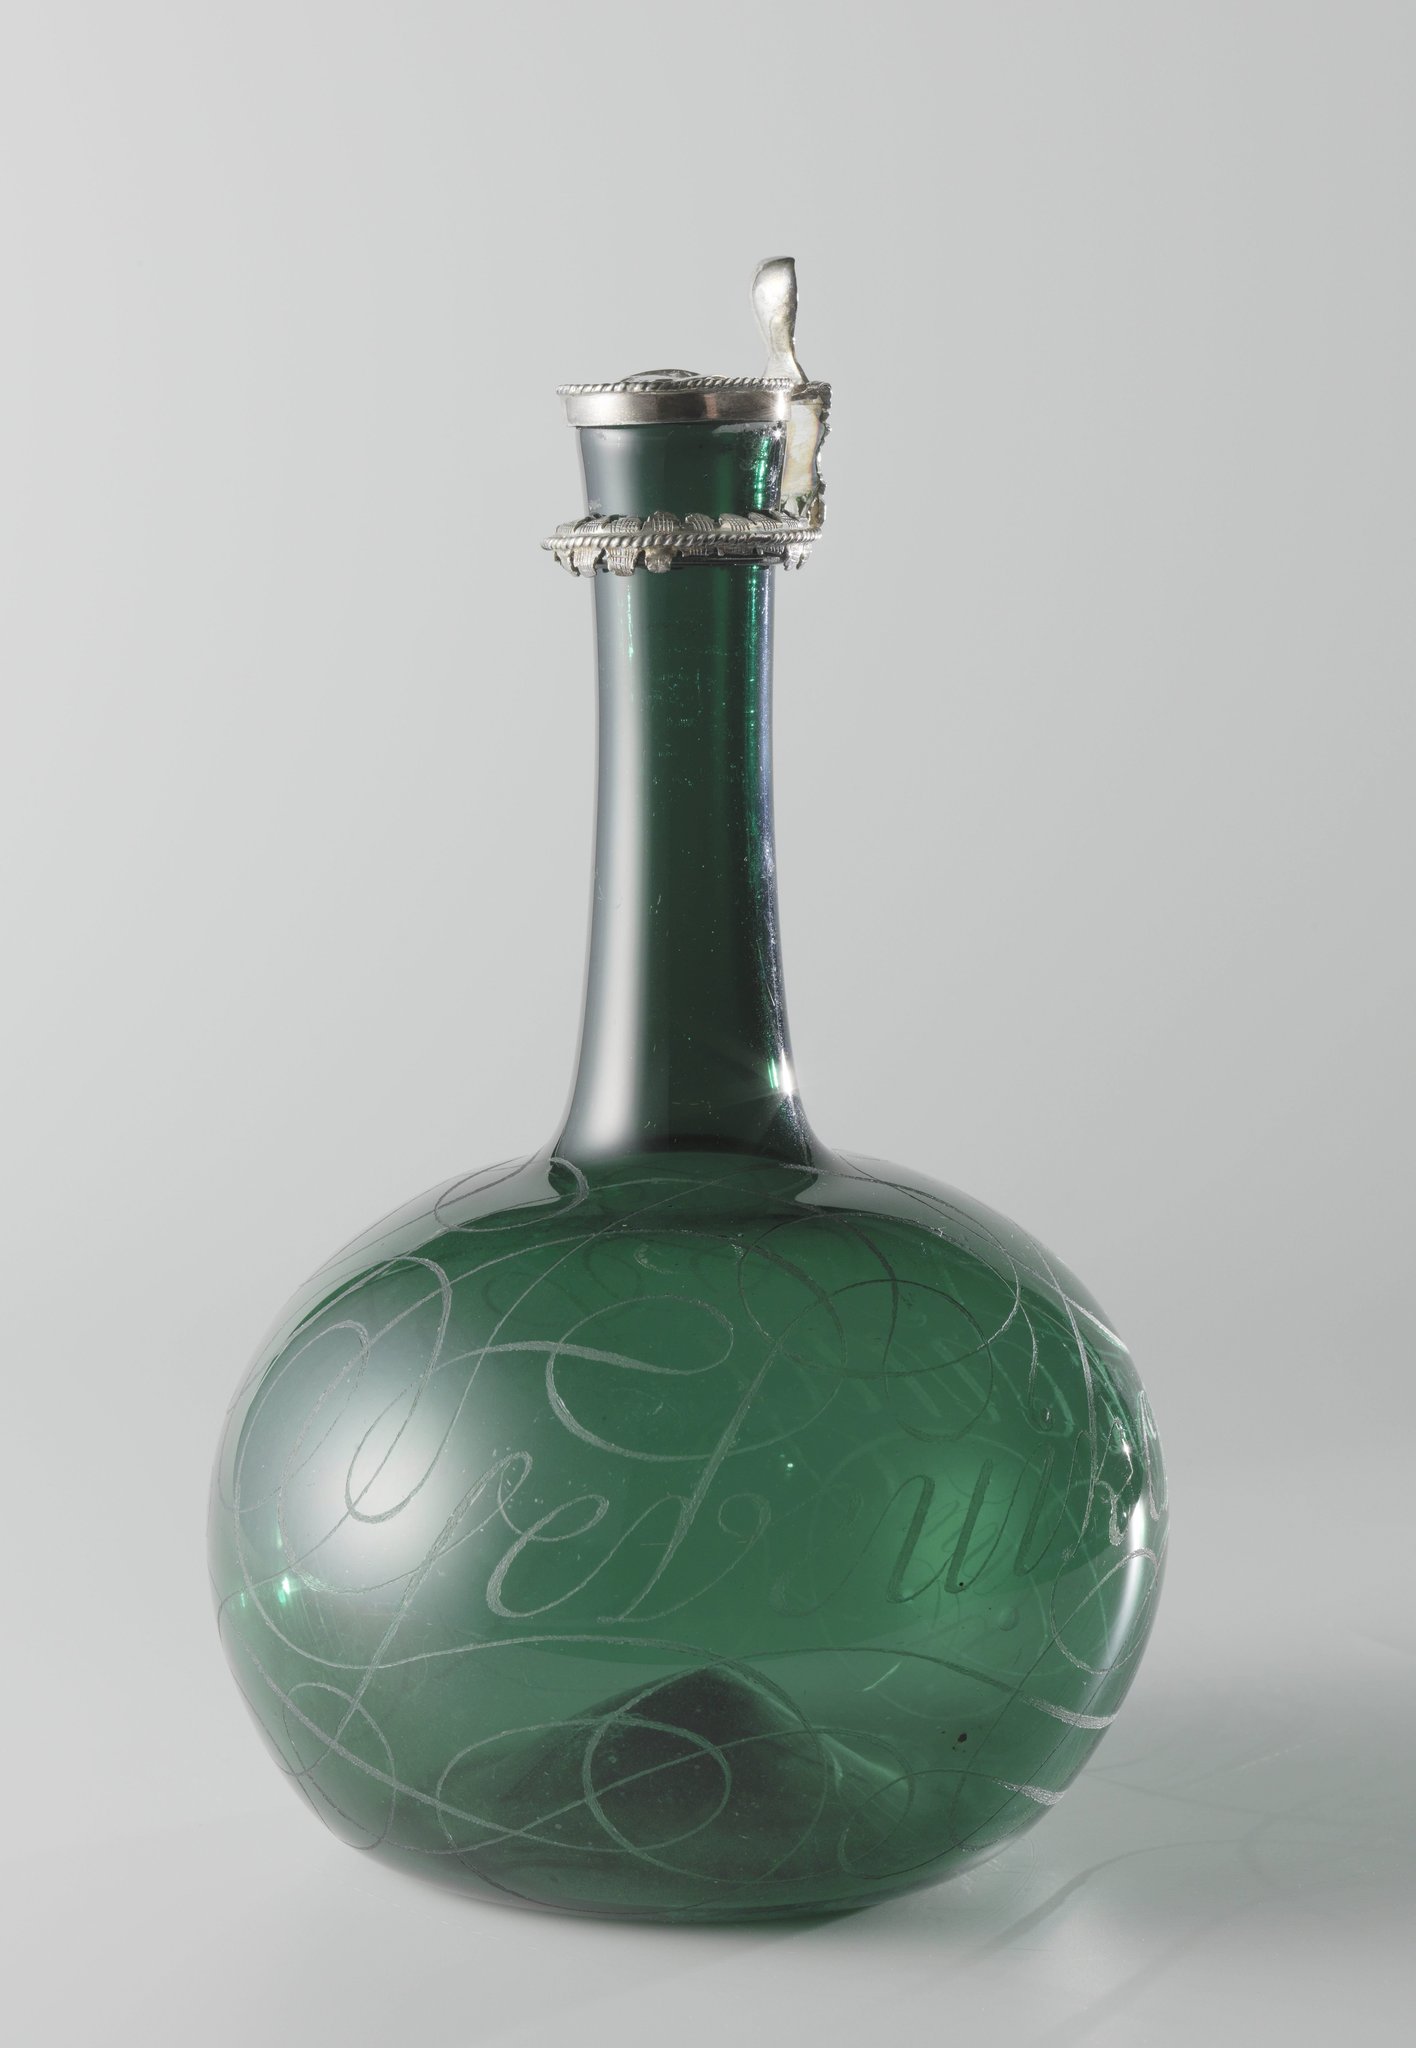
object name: bottle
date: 1684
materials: glass, silver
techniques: diamond point engraving, glassblowing, striking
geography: stockholm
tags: rome, christina (koningin van zweden)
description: The inscription on the body translates as: ‘Make use of everything’. The bottle was a gift to Catharina, one of the artist’s daughters.